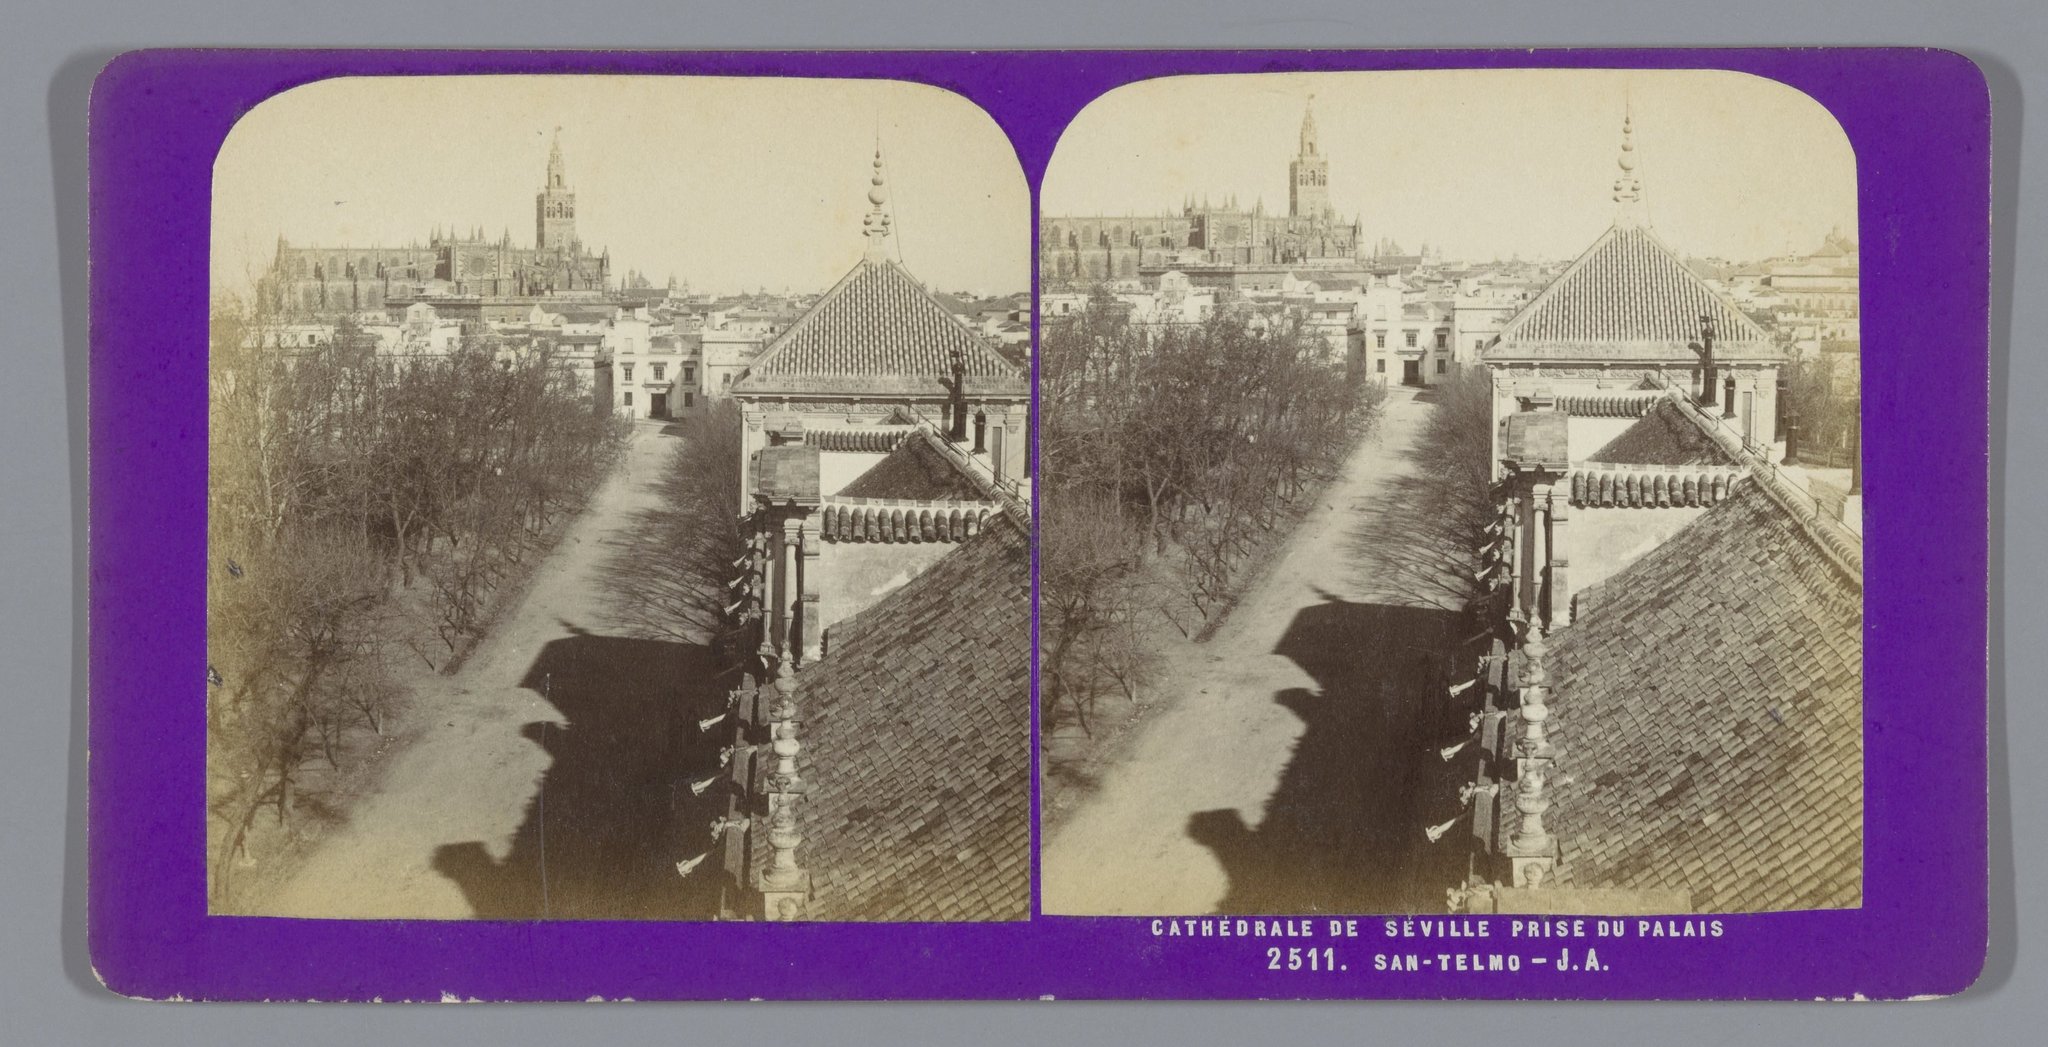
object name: stereograph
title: Cathédrale de Séville prise du Palais San-Telmo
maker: jean andrieu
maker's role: fotograaf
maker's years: 1816-1872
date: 1862-1876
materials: cardboard, photographic support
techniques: albumen print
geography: sevilla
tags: church (exterior), prospect of city, town panorama, silhouette of city, sevilla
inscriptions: number: ‘2511.’